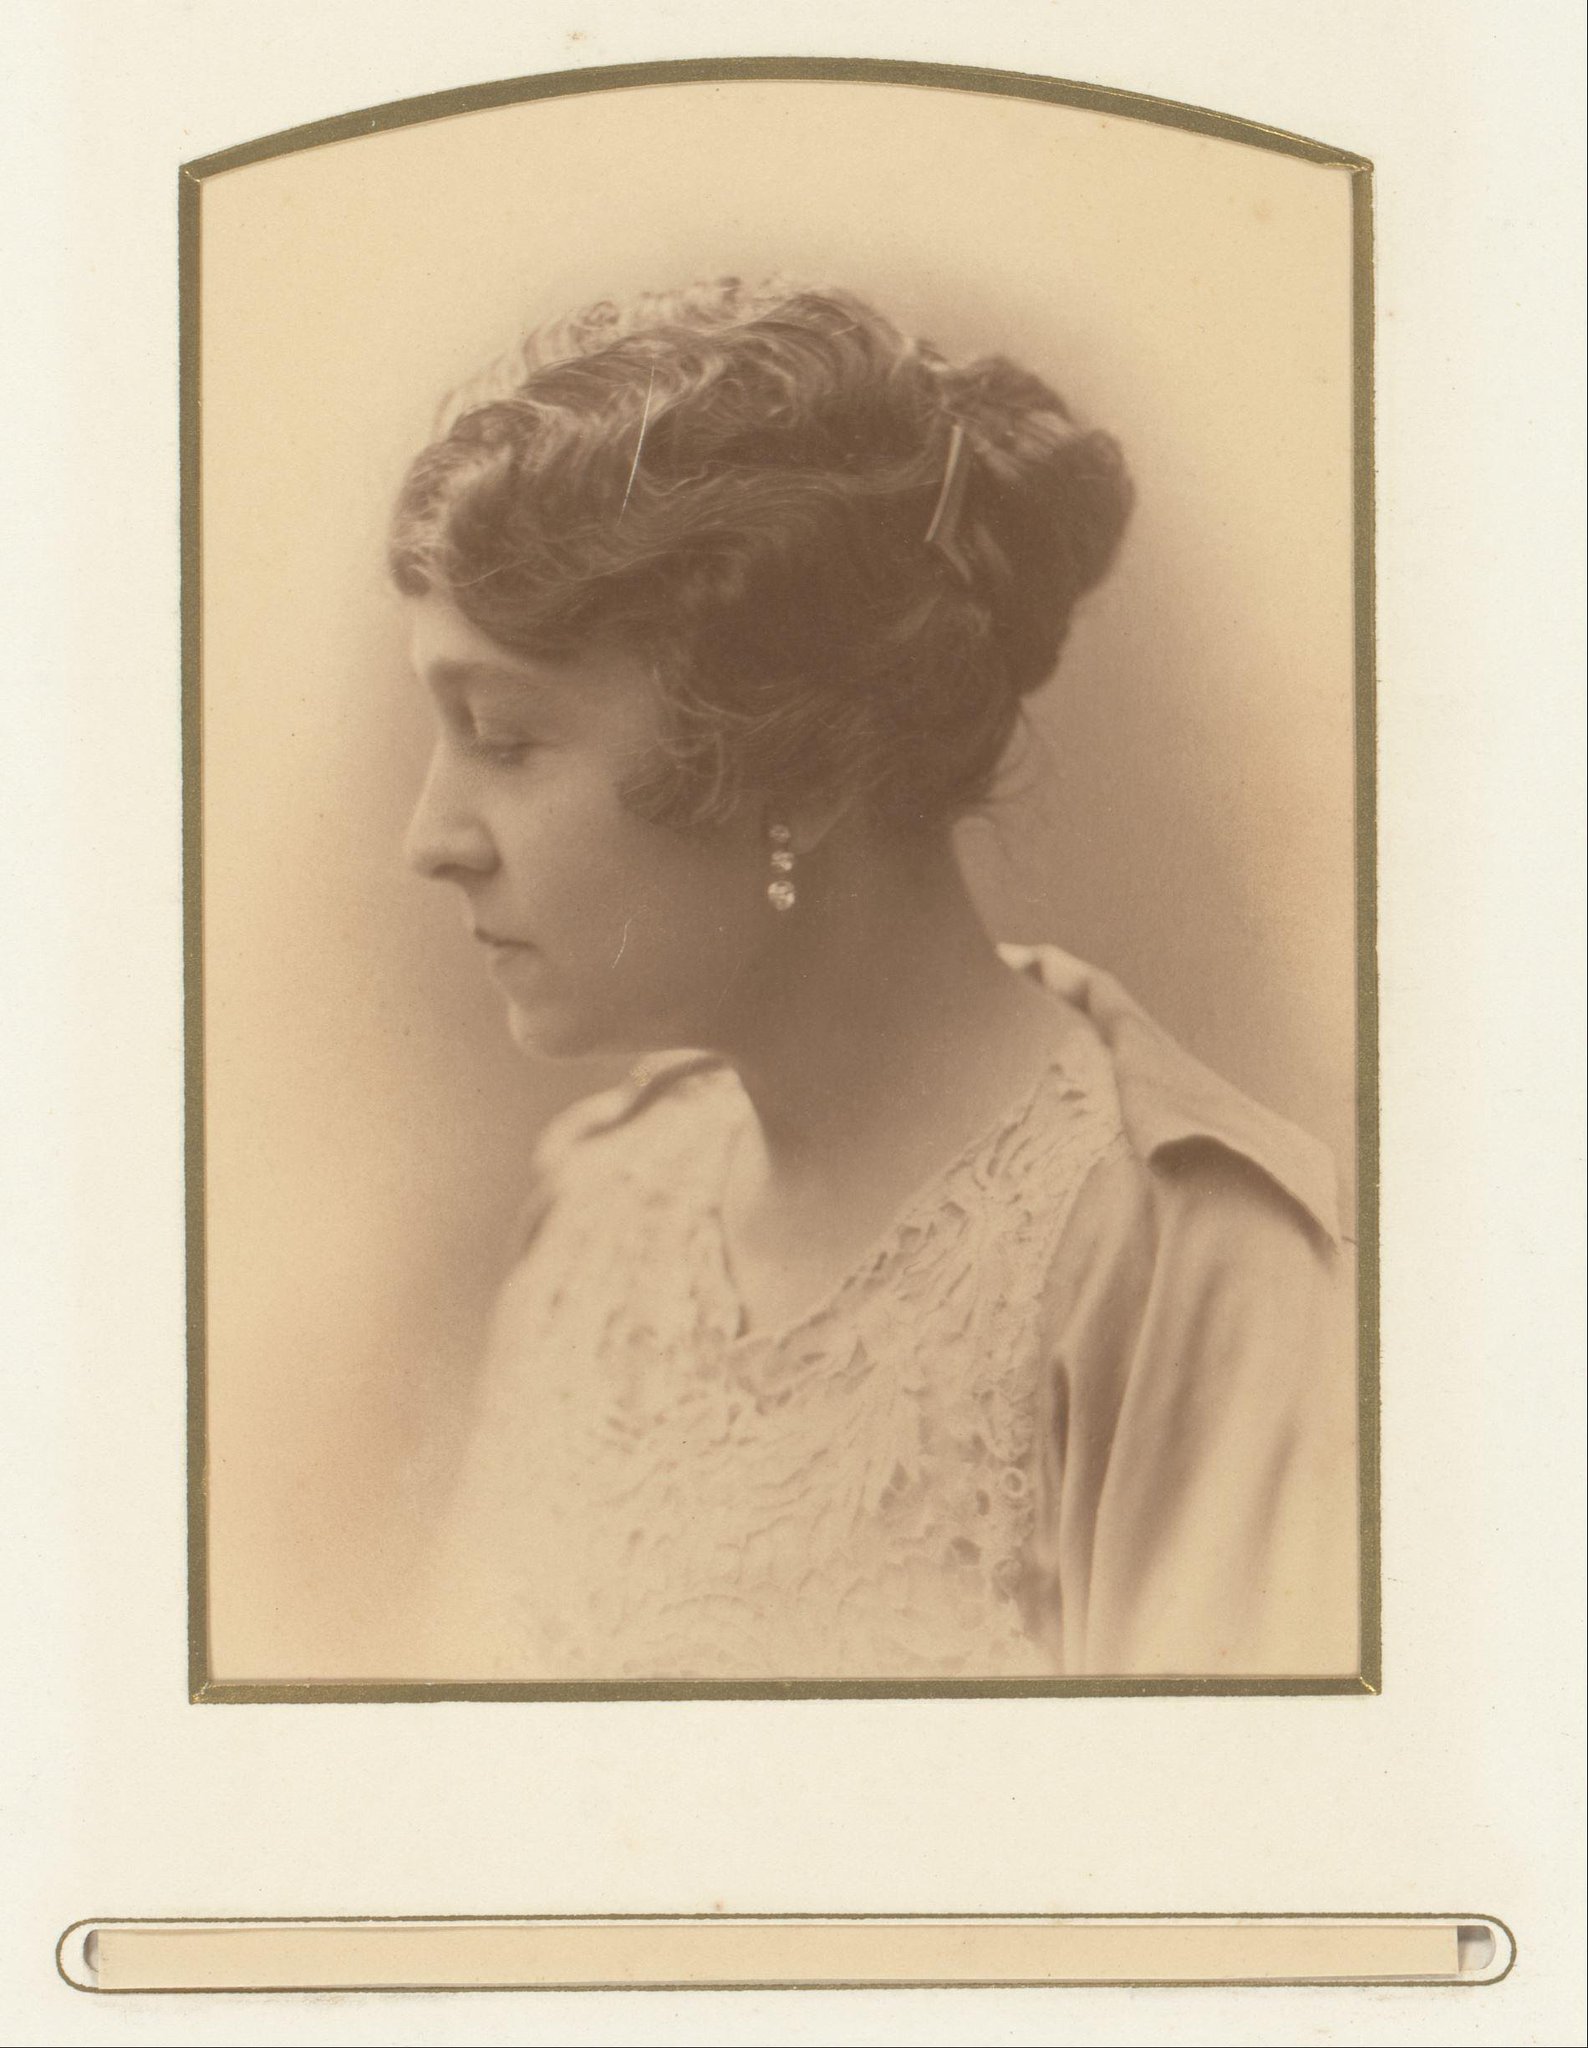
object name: album leaf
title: Portret van een vrouw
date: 1880-1940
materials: cardboard, photographic support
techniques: collodion silver print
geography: folkestone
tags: historical persons - bb - woman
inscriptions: inscription: ‘Copyright./ Photograph by/ Telephone/ No 29 Y/ J. WESTON & SON,/ 20a SANDGATE ROAD,/ FOLKESTONE.’, annotation: ‘341 x 2’